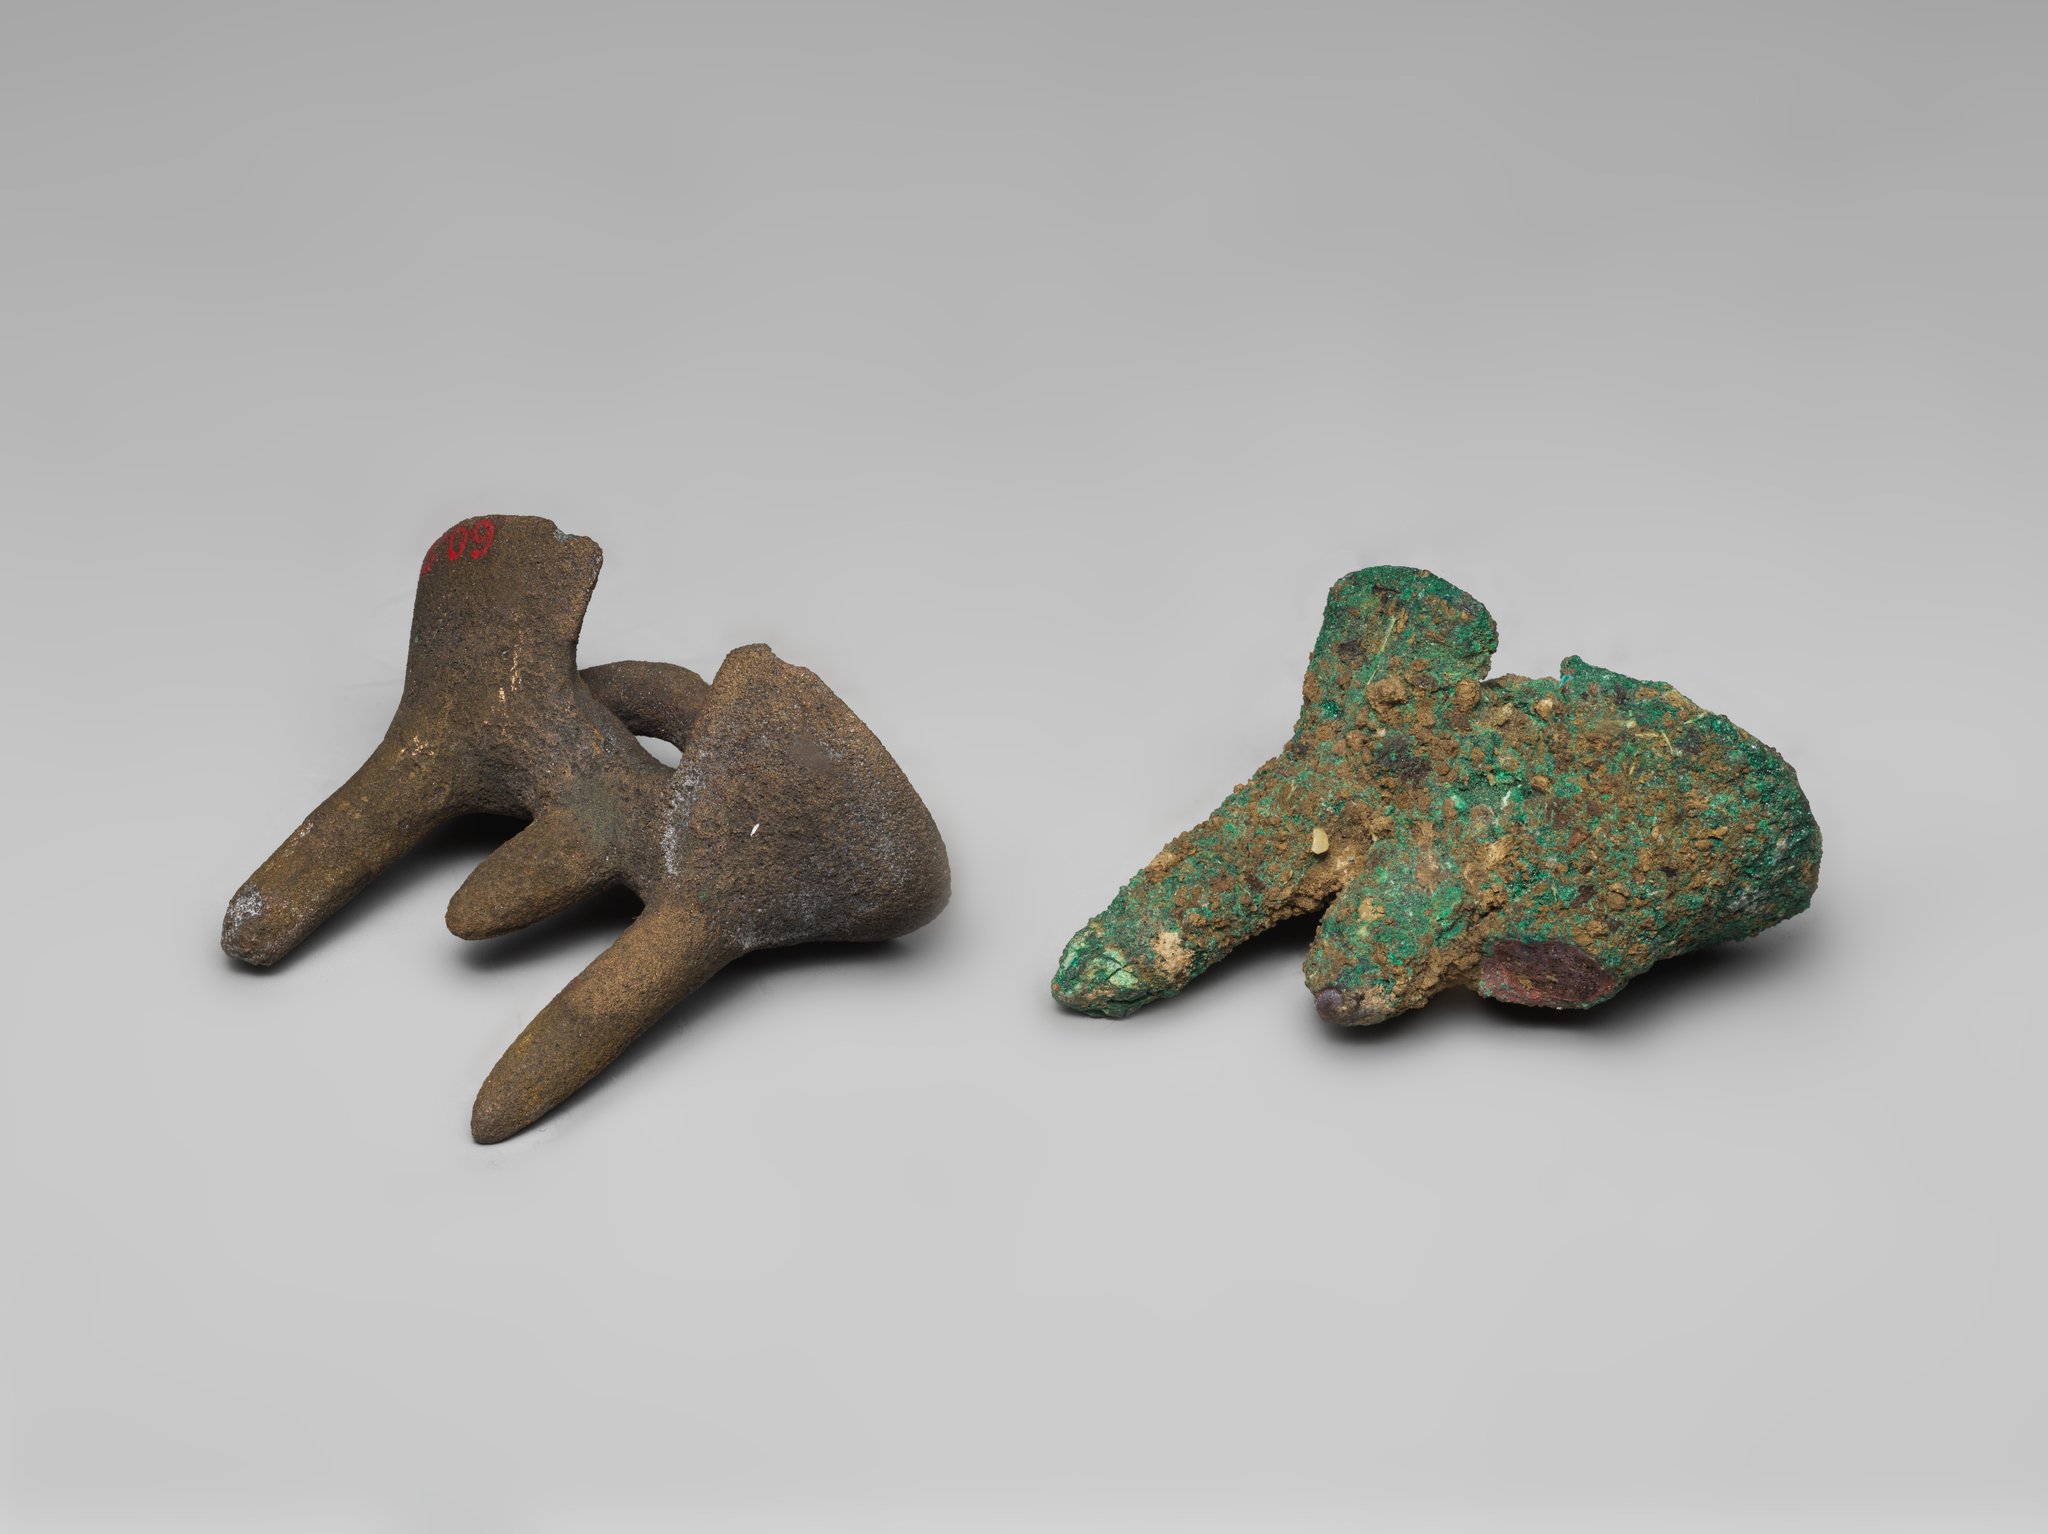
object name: harness or bridle fitting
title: Harness or bridle fittings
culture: iranian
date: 900-801 BCE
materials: bronze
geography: iran